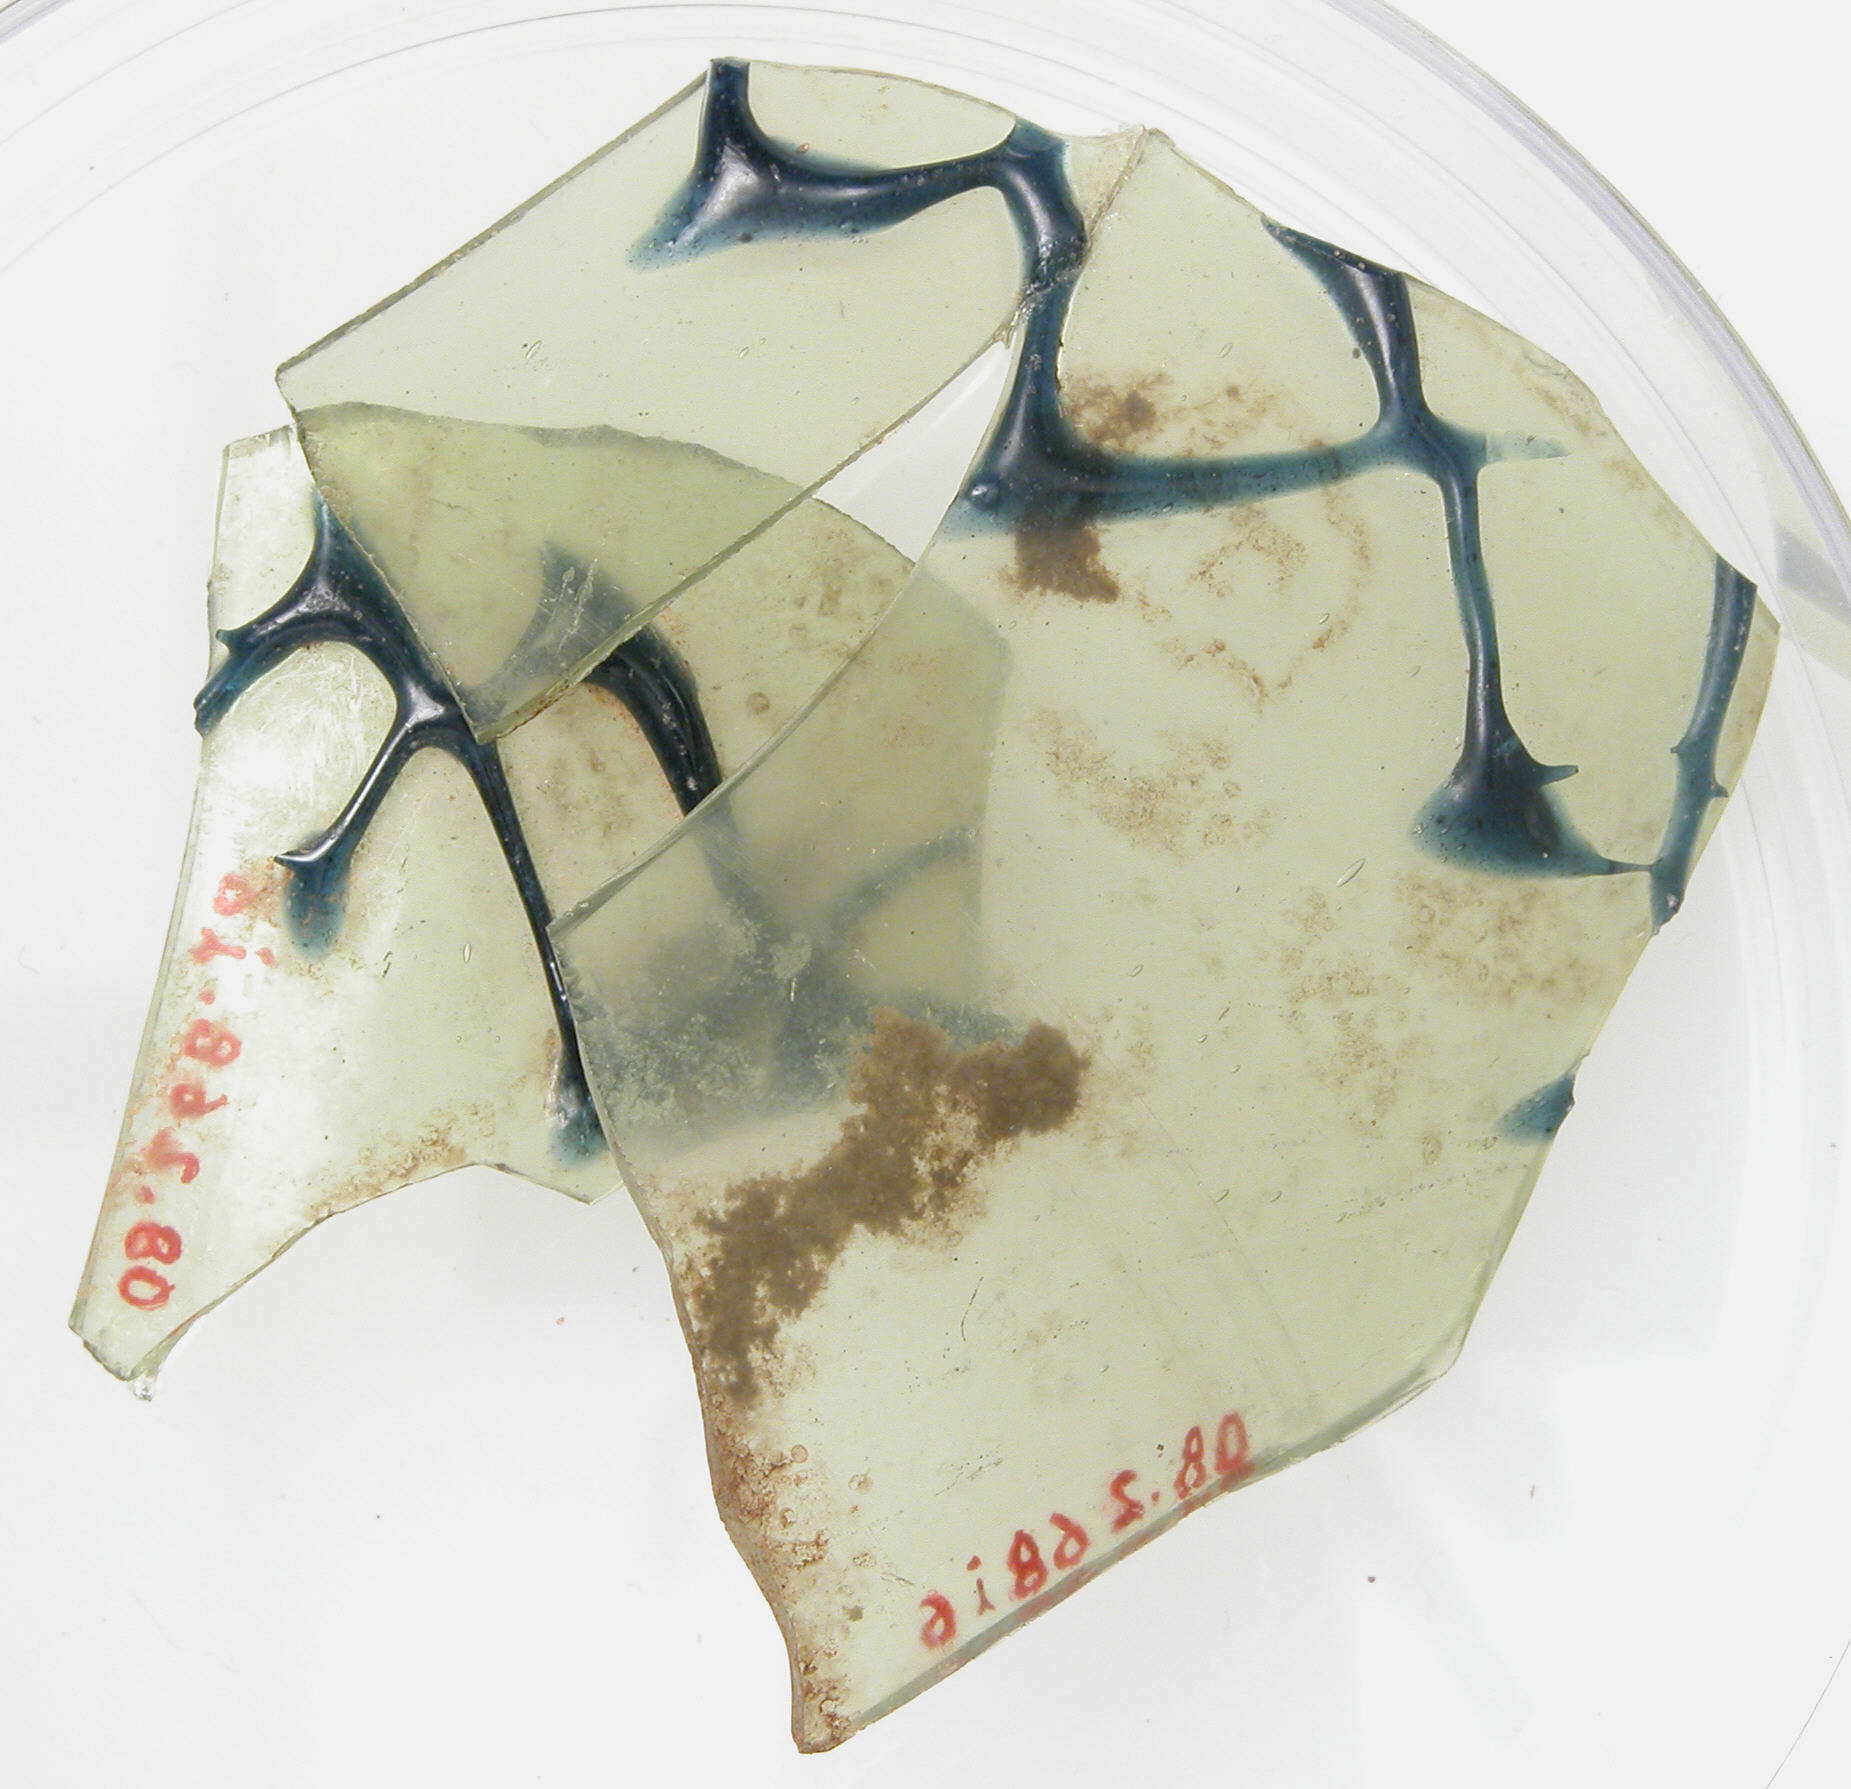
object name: fragment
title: Glass Fragments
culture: coptic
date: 301-433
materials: glass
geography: egypt